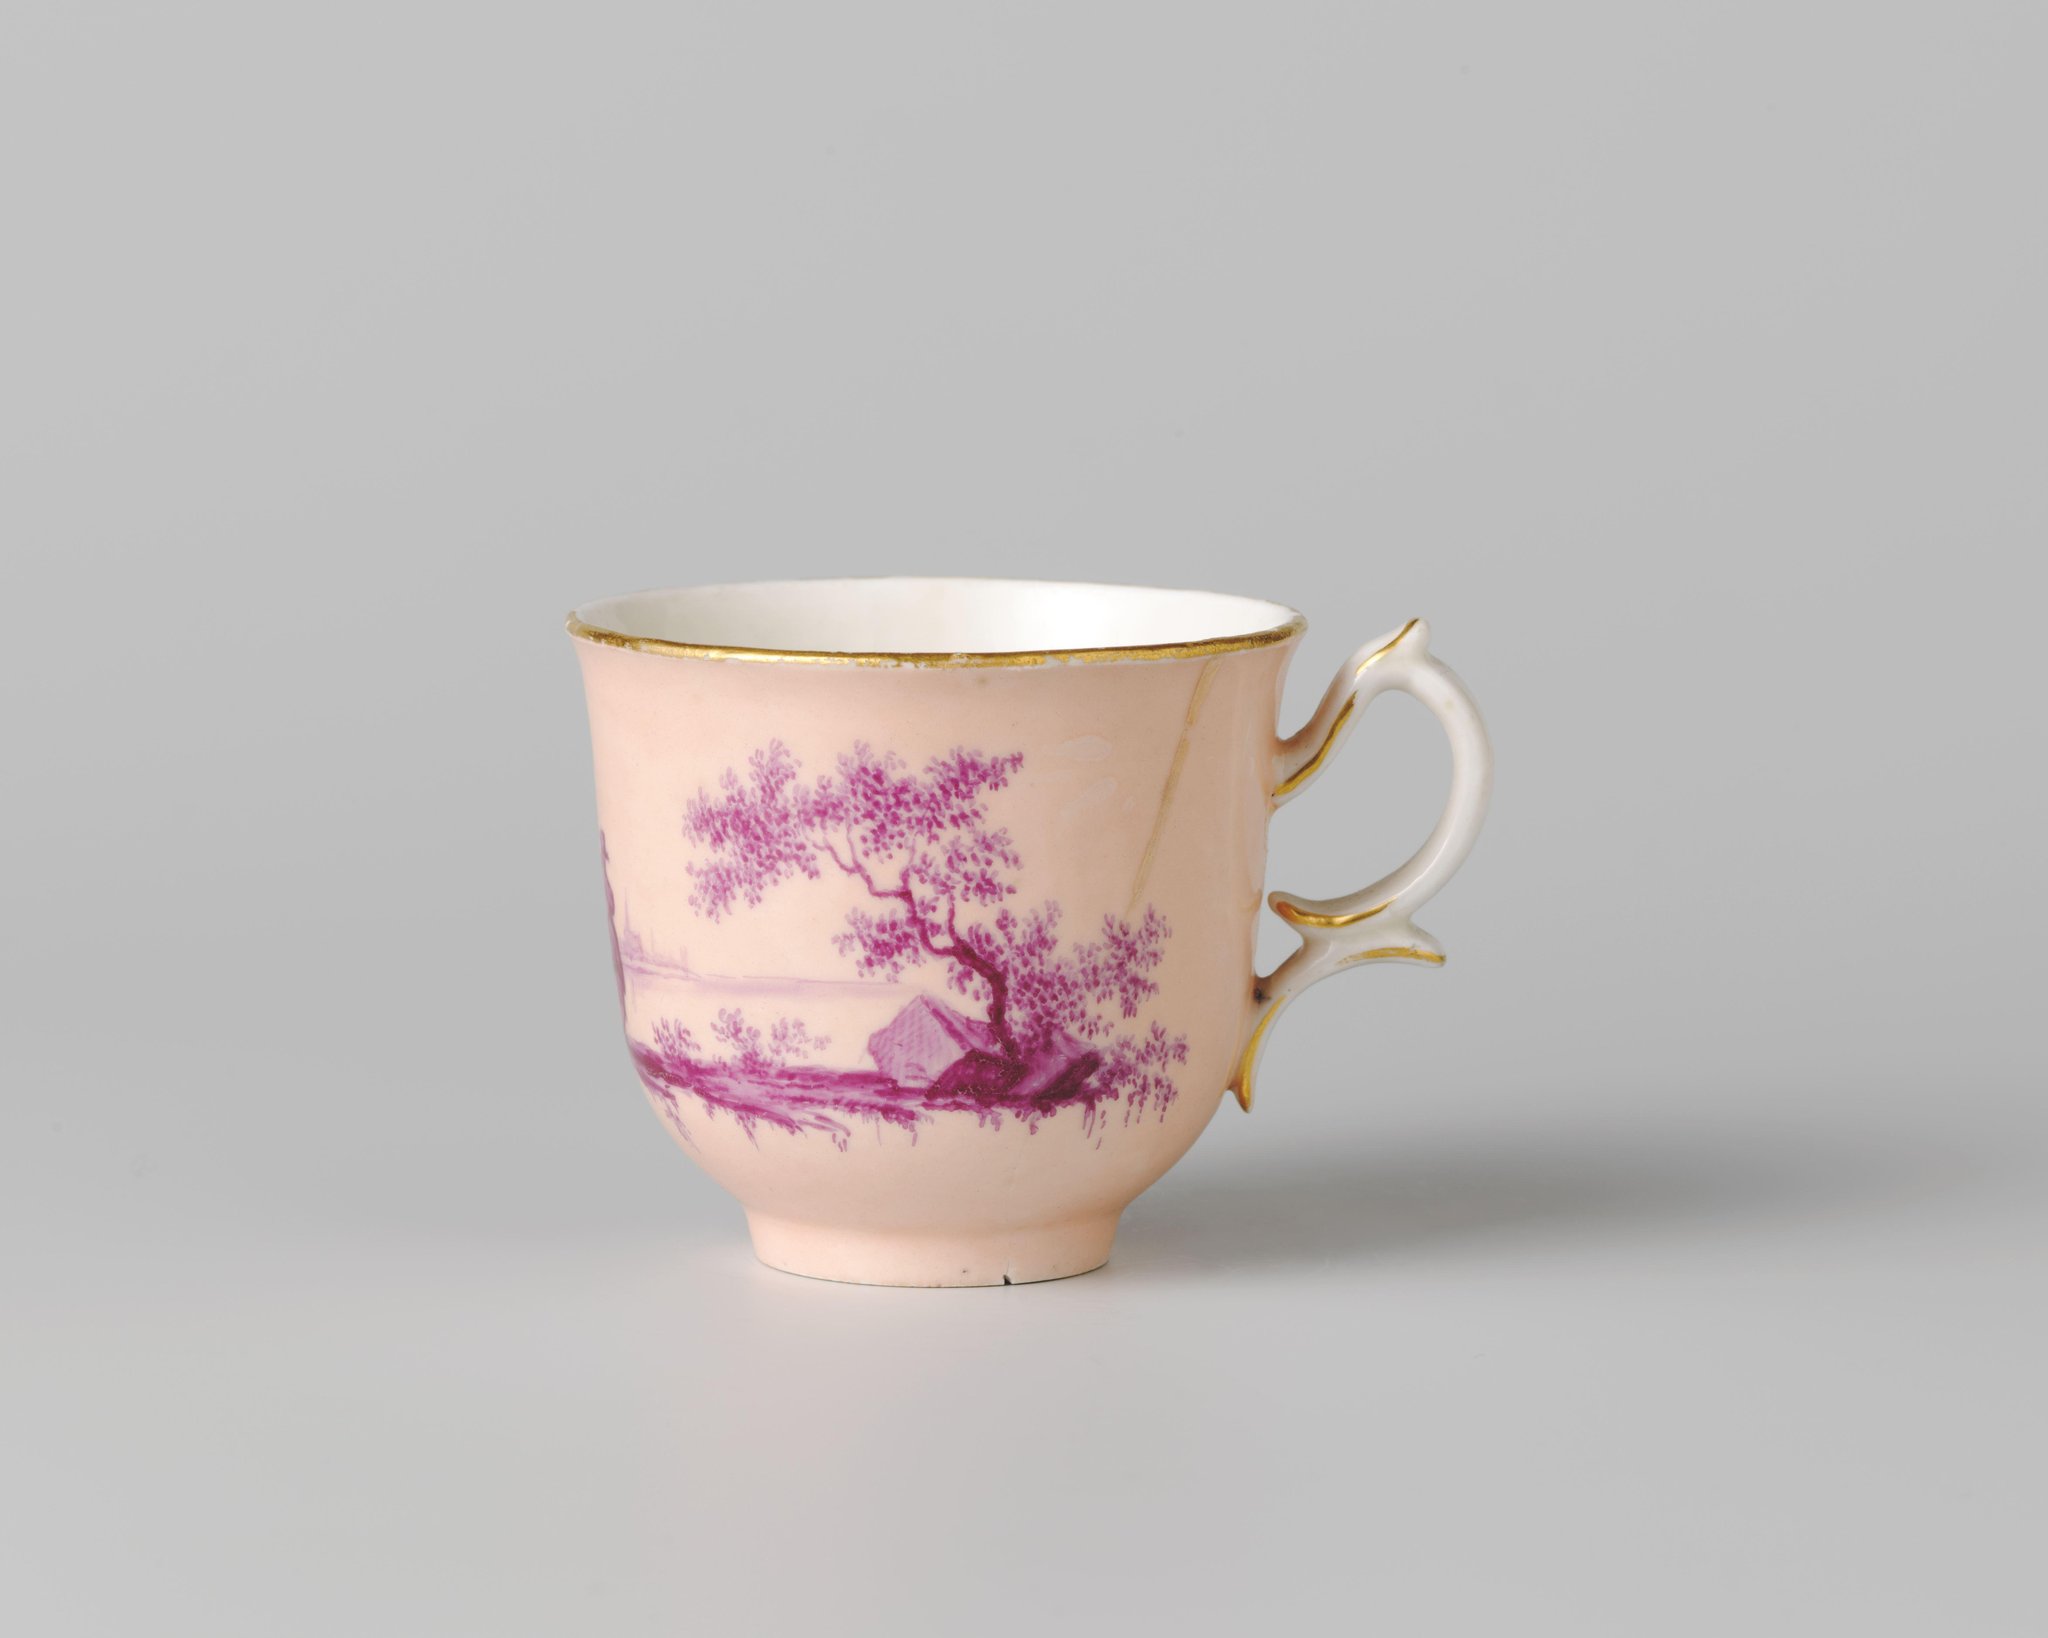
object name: cup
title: Koffiekop van een koffie- en theeservies, beschilderd met figuren in een rivierenlandschap in bietenrood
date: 1774-1778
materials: porcelain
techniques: painted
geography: loosdrecht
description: Parts of a tea and coffee service with pink ground. Porcelain. Loosdrecht, c. 1774 - 1776. Factory of Joannes de Mol.